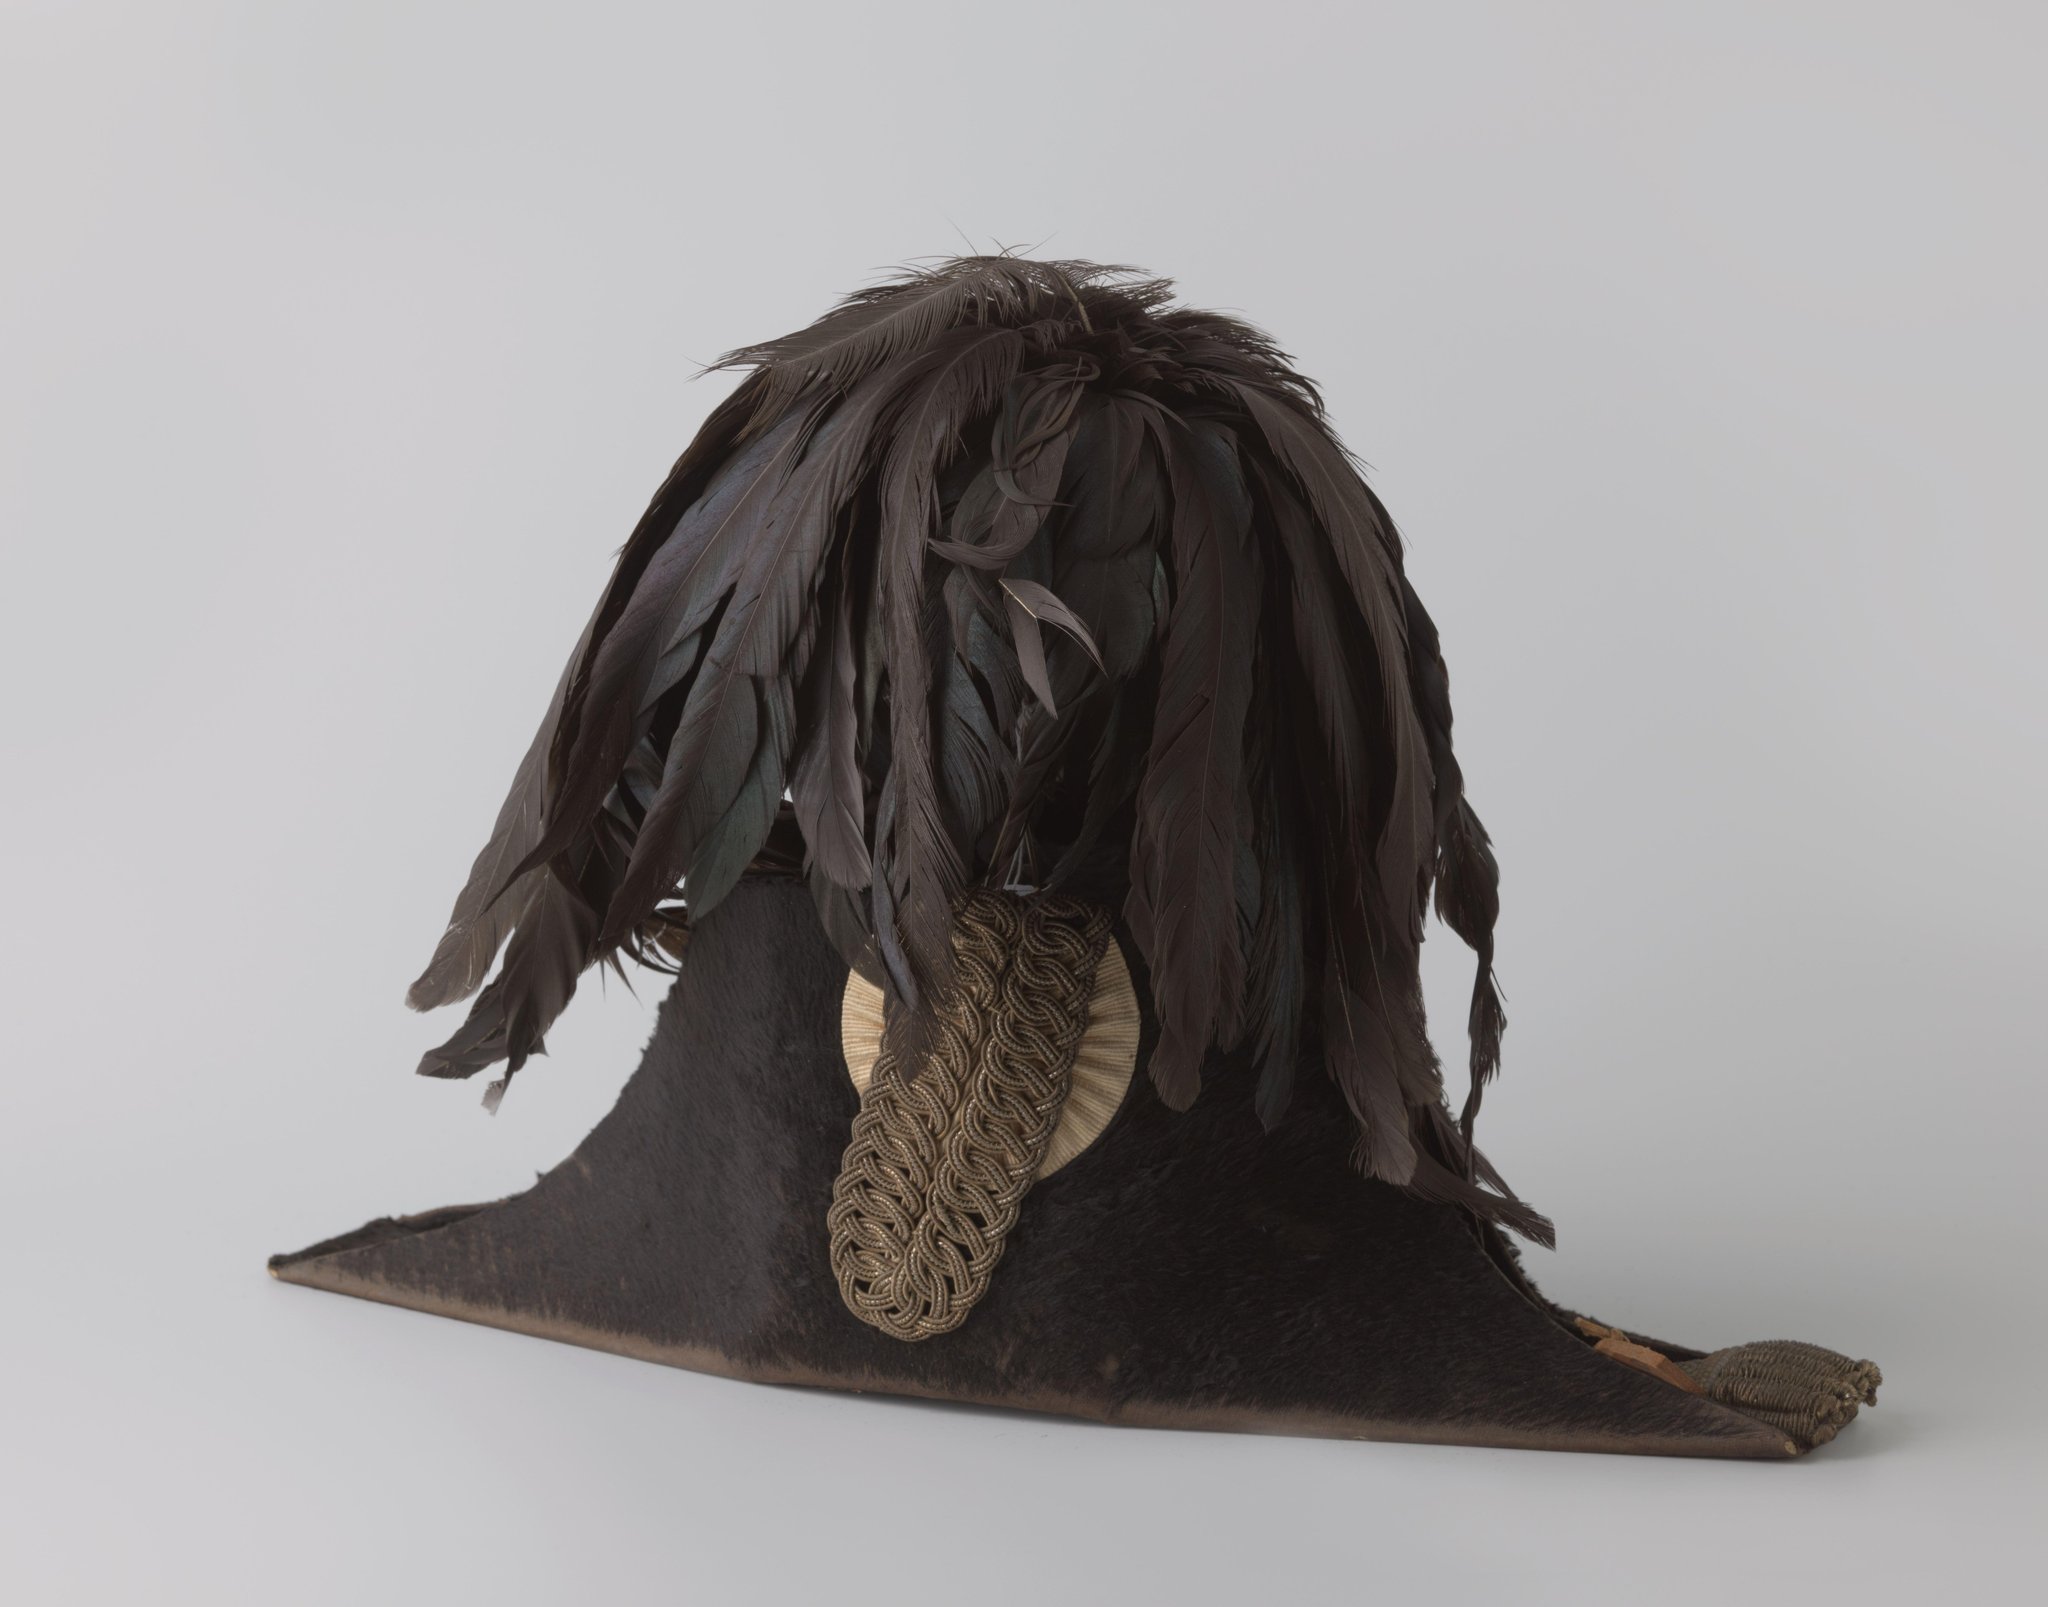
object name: corsaire, bicorne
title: Bicorne officier ca. 1830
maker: Anonymous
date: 1800-1850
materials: cardboard, feather, felt, silk, thread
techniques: braiding, forming, pressing, stitching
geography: netherlands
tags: netherlands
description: Hoofddeksel van kastoor. Aan linker opgeslagen zijde een oranje zijden kokarde, waarop een gouden lis. Aan de binnenzijde hiervan een leren lus (voor het aanbrengen van de pluim). Voorzijde steek platte zilveren kwast. Binnenwerk van rode zijde.